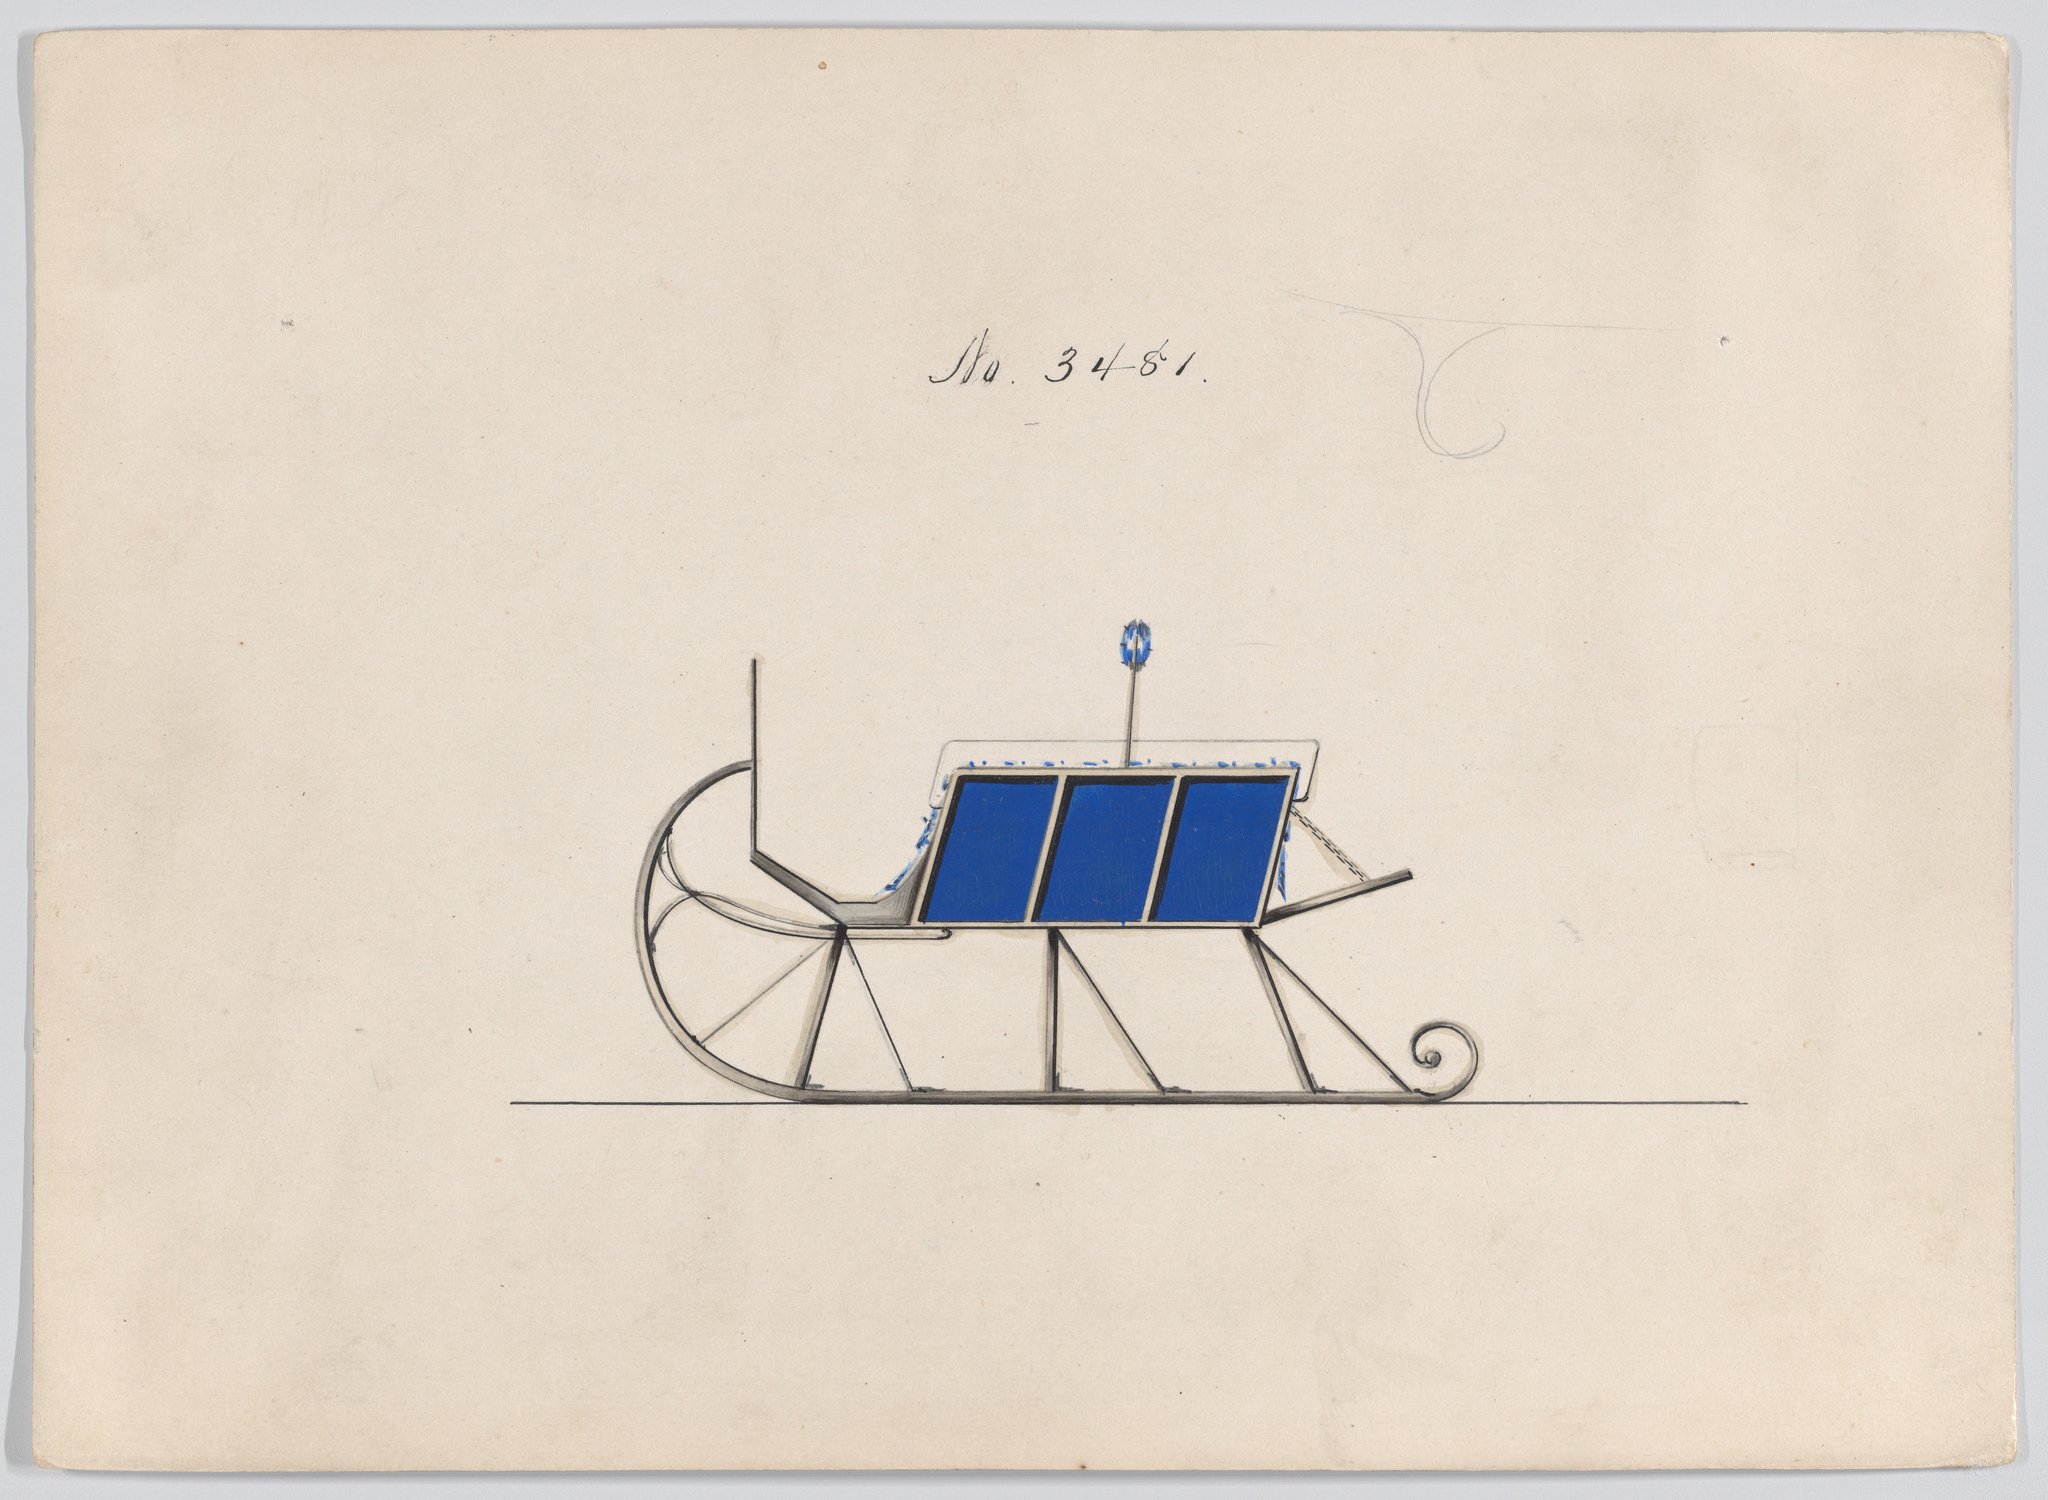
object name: drawing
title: Design for Dos-a-Dos Sleigh, no. 3481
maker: brewster & co.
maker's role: manufacturer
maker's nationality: american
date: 1879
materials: gouache, gum arabic, ink, watercolor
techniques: pen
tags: sleighs